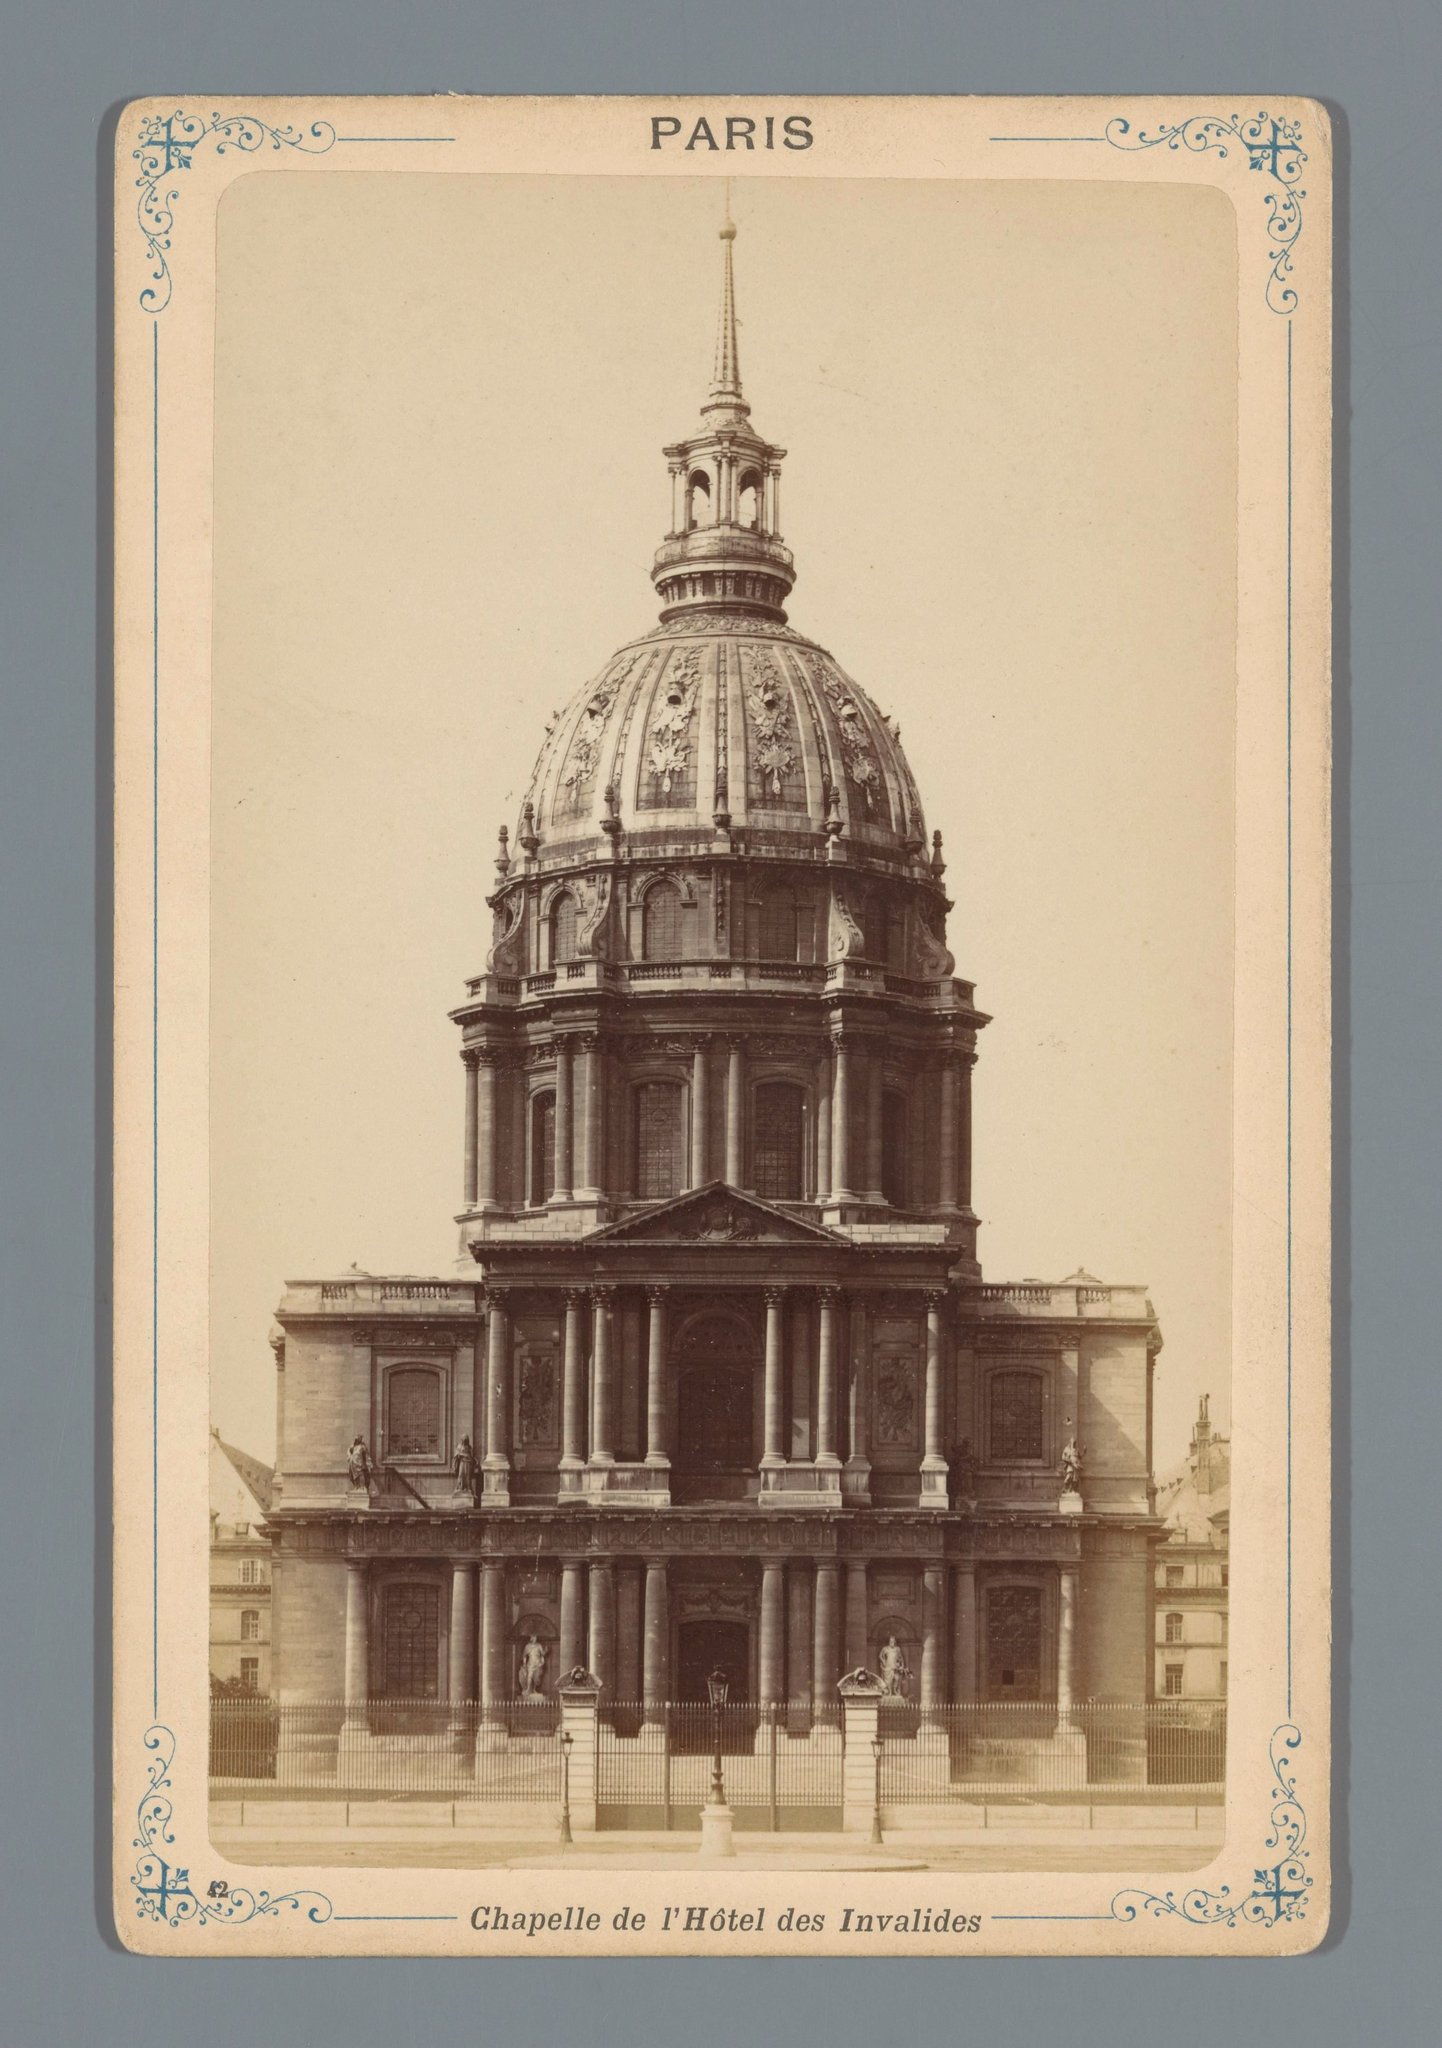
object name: photograph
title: Paris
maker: étienne neurdein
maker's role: publisher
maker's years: 1832-1918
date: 1870-1900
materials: cardboard, photographic support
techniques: albumen print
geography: paris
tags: parts of church exterior and annexes - qq - small church, chapel, façade (of house or building)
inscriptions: number: ‘42’, retailer's mark: ‘VUES DE PARIS/ F. HELAINE/ 206, Rue de Rivoli/ Monocles-Graphoscopes’